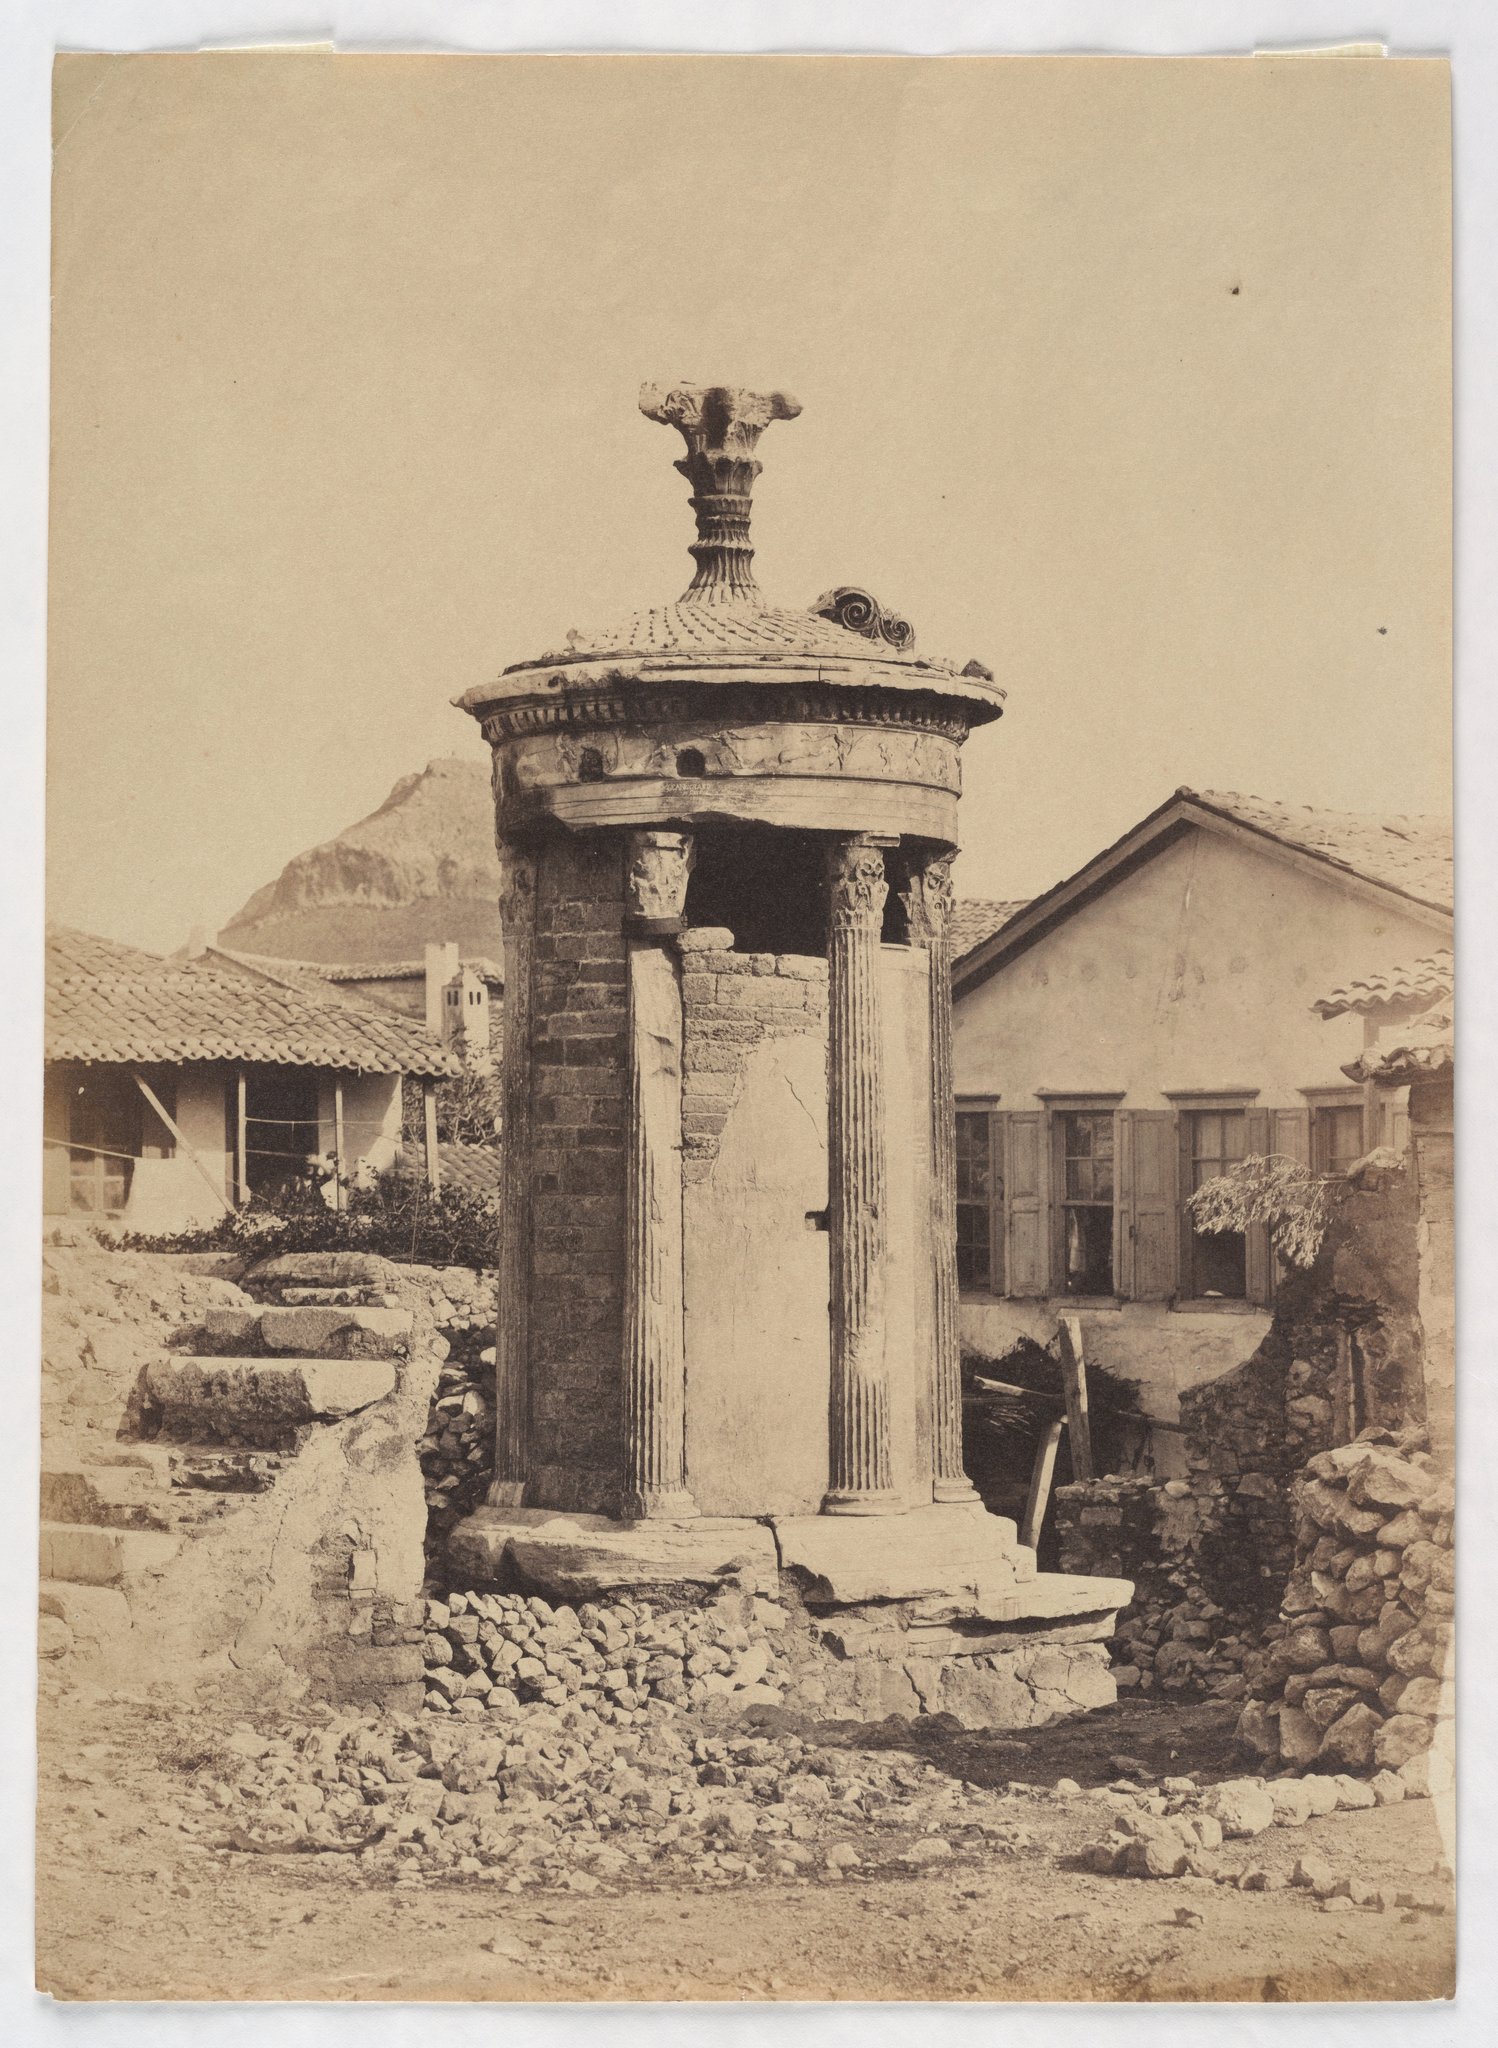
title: [Acropolis, Athens, Greece]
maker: james robertson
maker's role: artist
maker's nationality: british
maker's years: 1813-1881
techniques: salted paper print